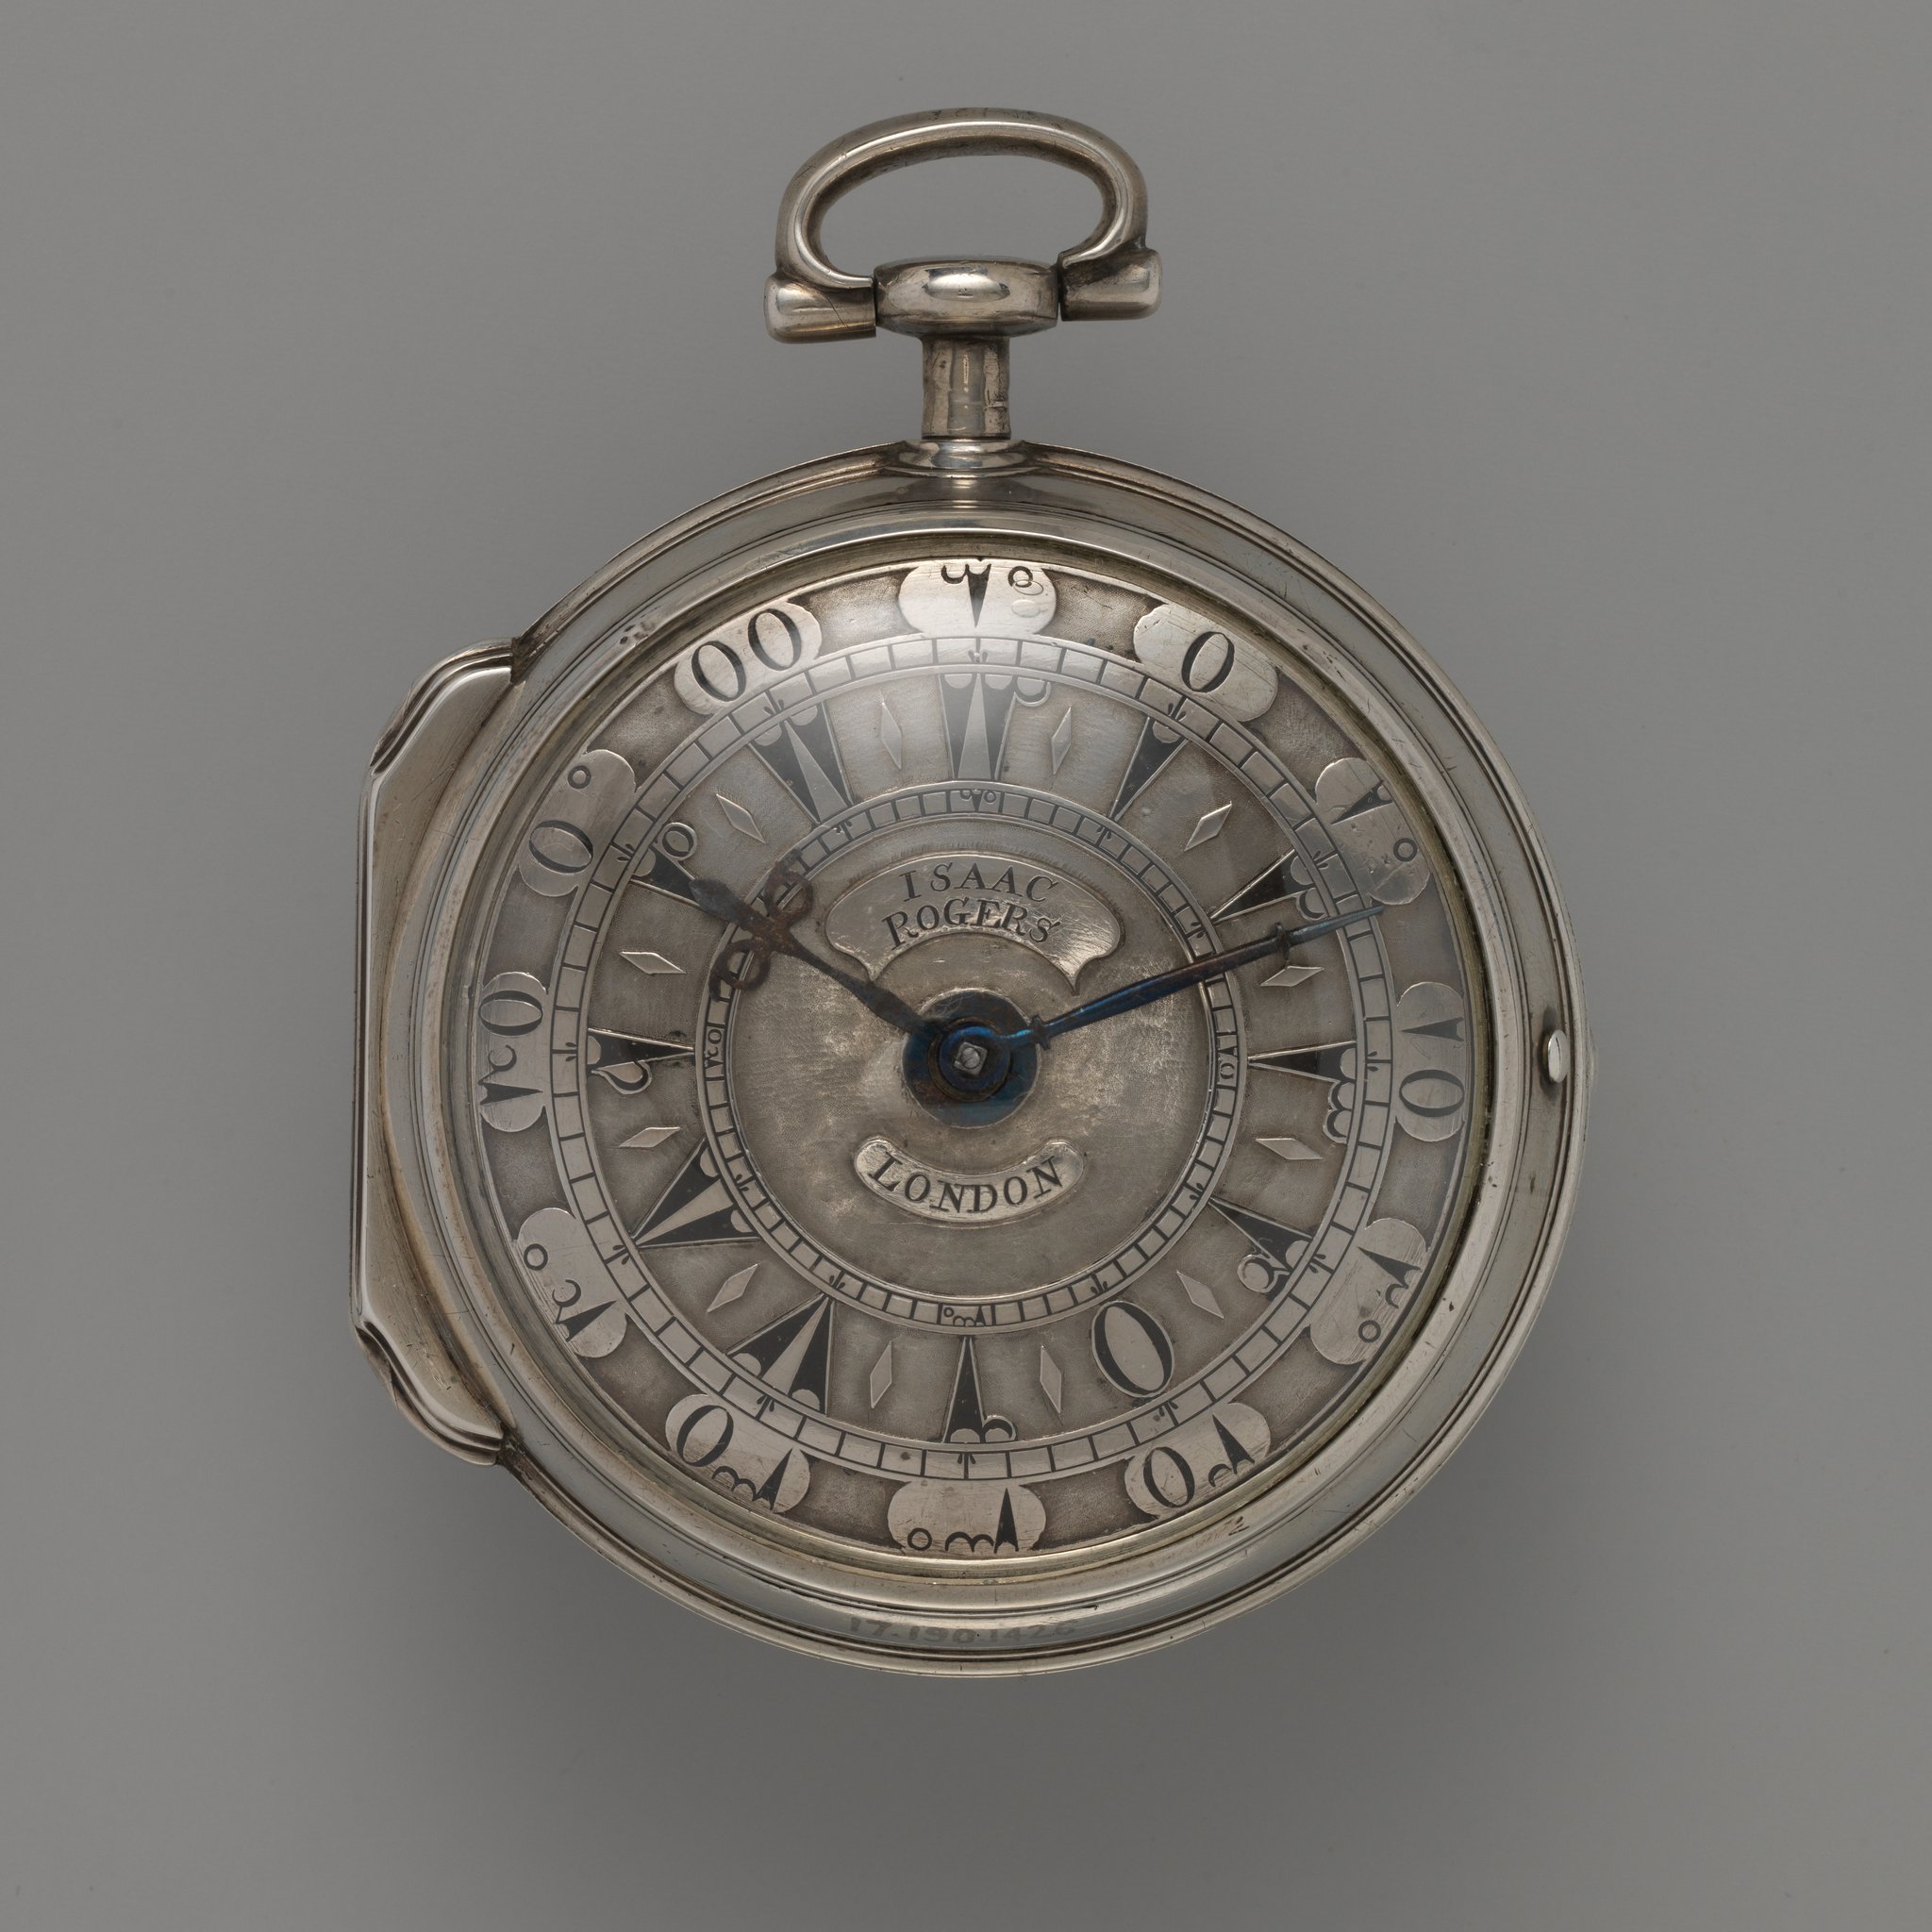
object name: watch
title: Traveling watch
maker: isaac rogers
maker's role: maker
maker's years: 1700-1800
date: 1759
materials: silver